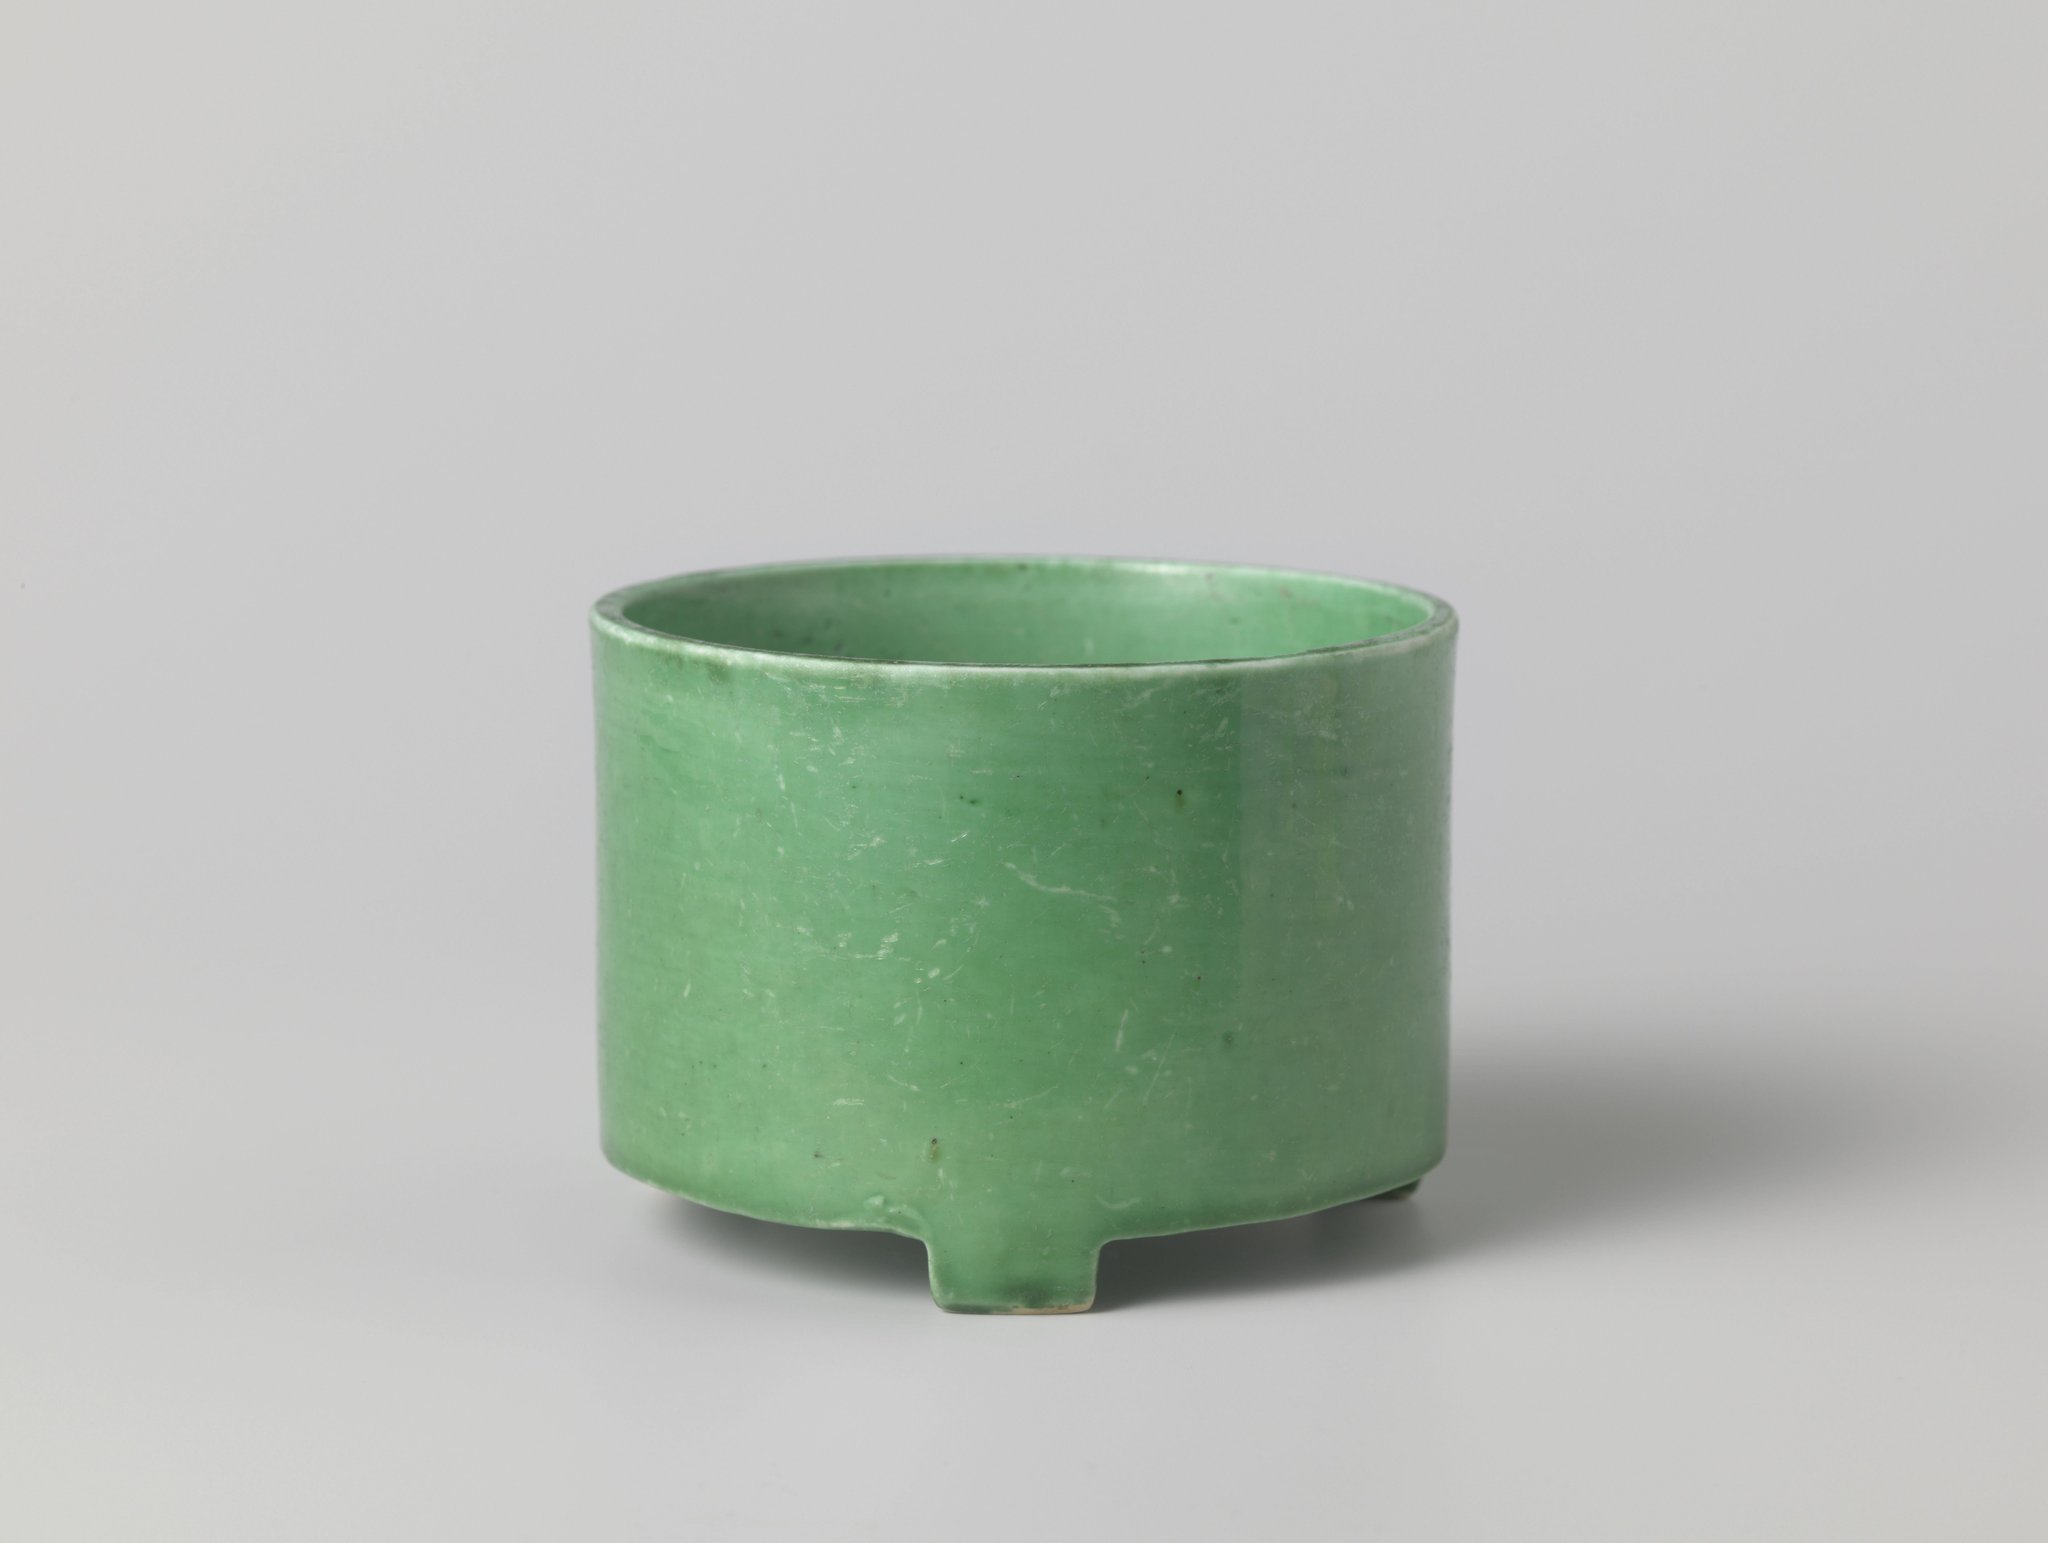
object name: incense burner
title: Green Glazed Censer on feet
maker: Anonymous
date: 1650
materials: glaze, porcelain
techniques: firing, turning, vitrification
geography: china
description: The green colour derives from copper and lead oxides. This colour was used in Jingdezhen from around 1550, but was initially dark and ran unevenly over the surface. In the 18th century a uniform fresh, apple green colour was achieved. It was made opaque through the addition of tin oxide.